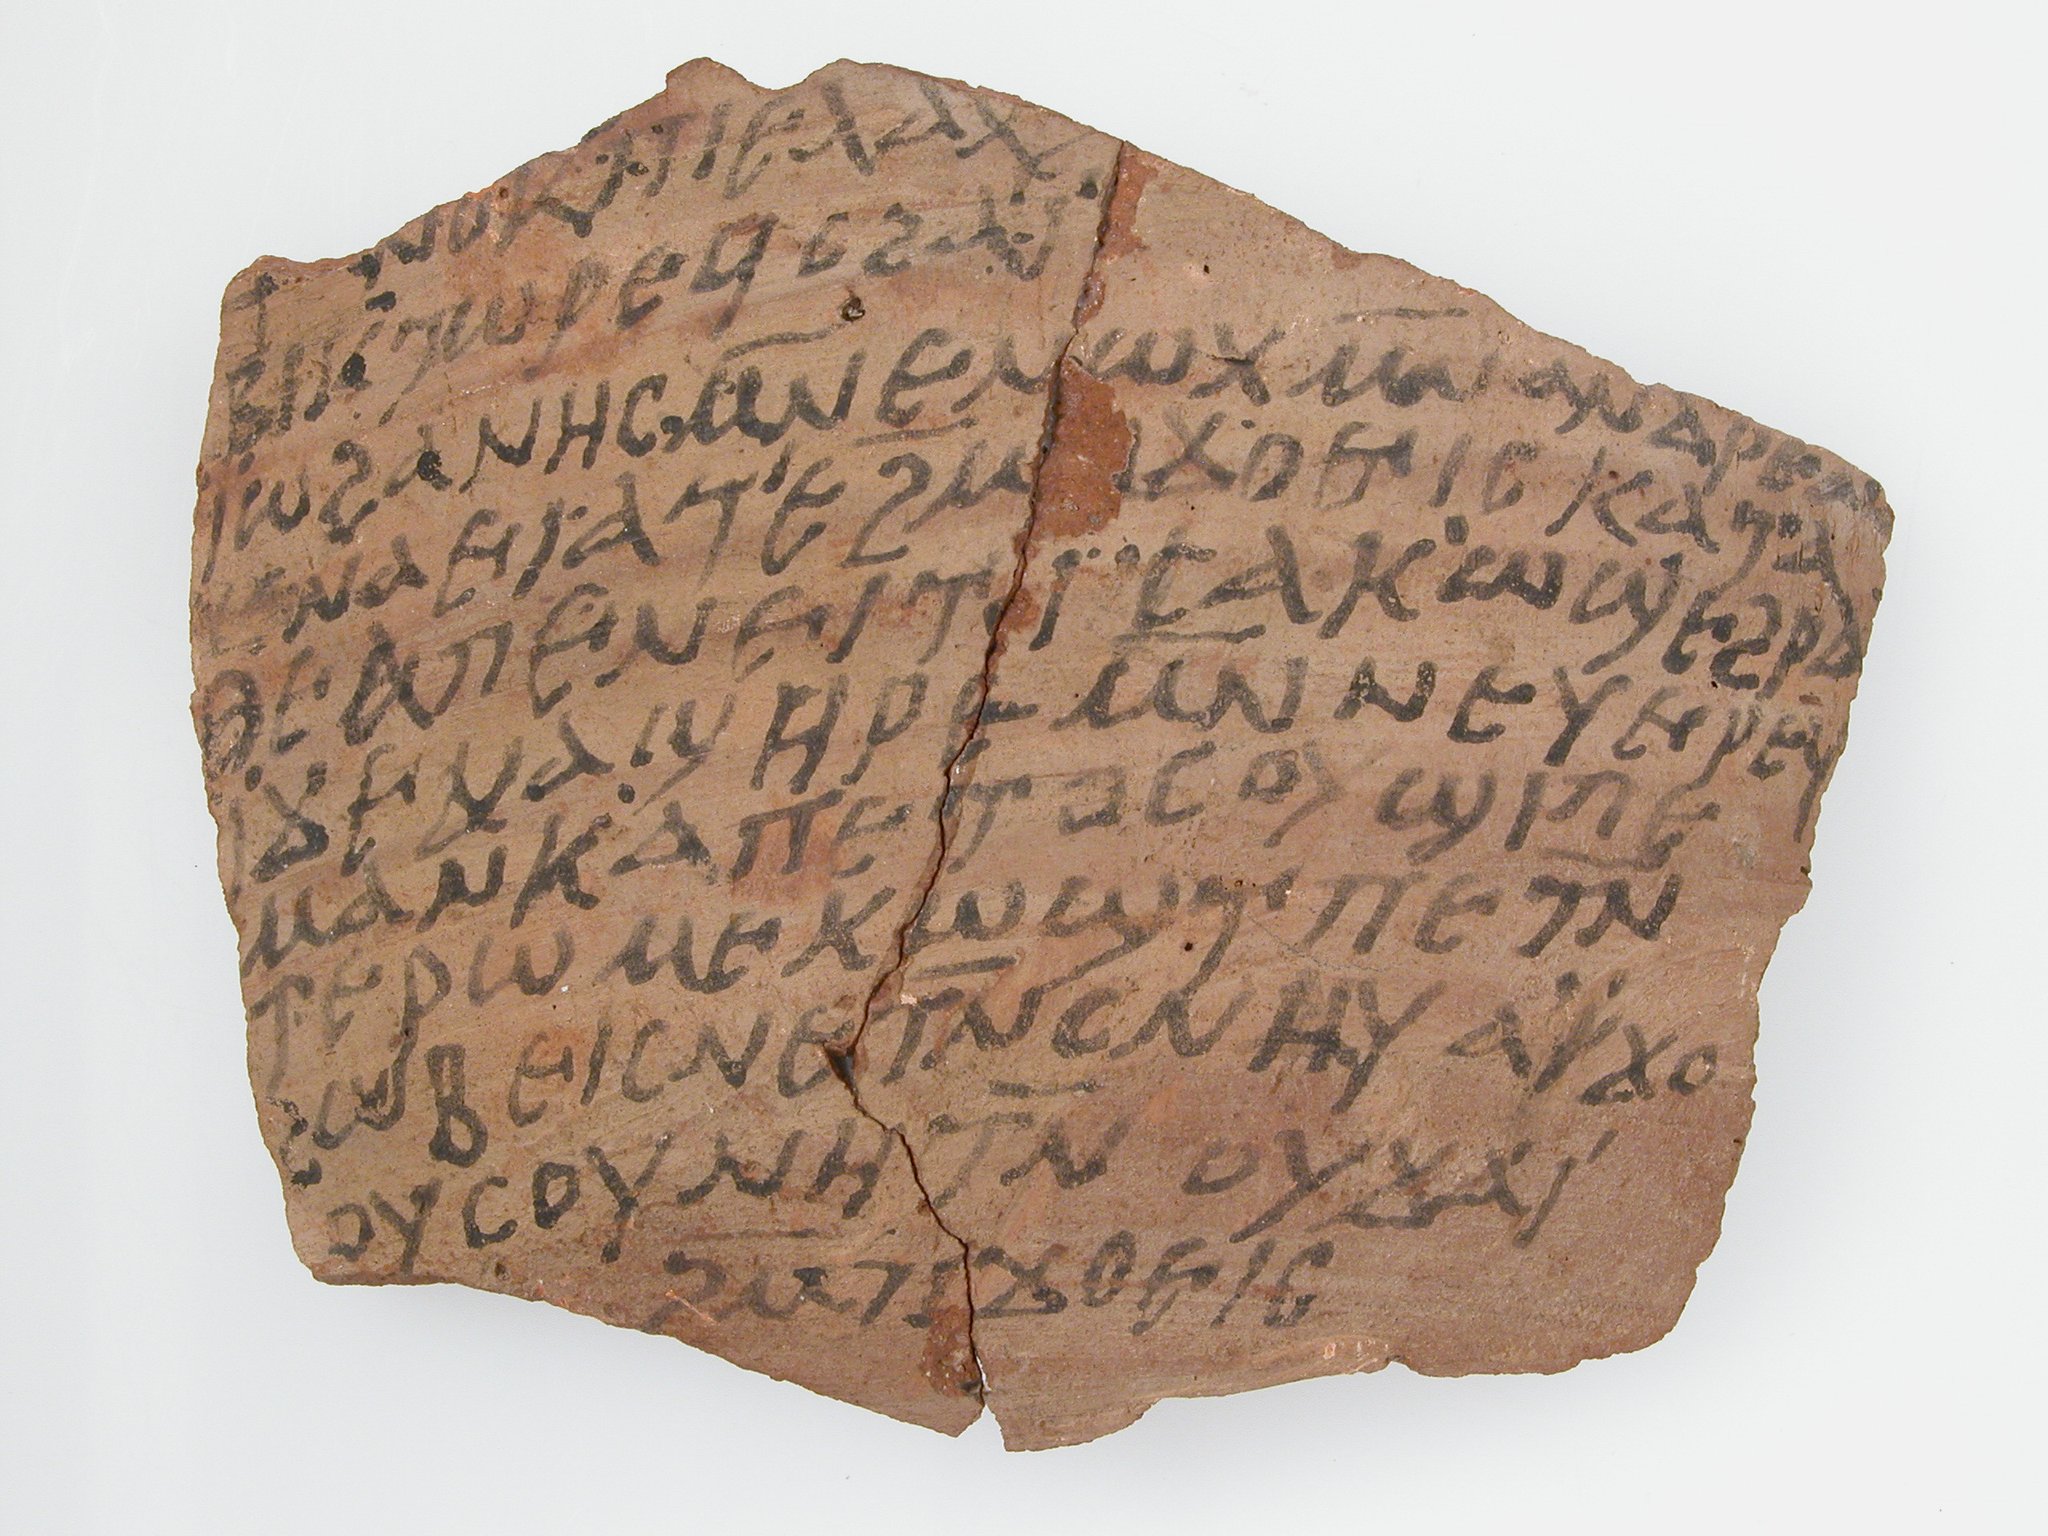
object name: ostrakon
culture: coptic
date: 601-700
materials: ink, pottery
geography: egypt